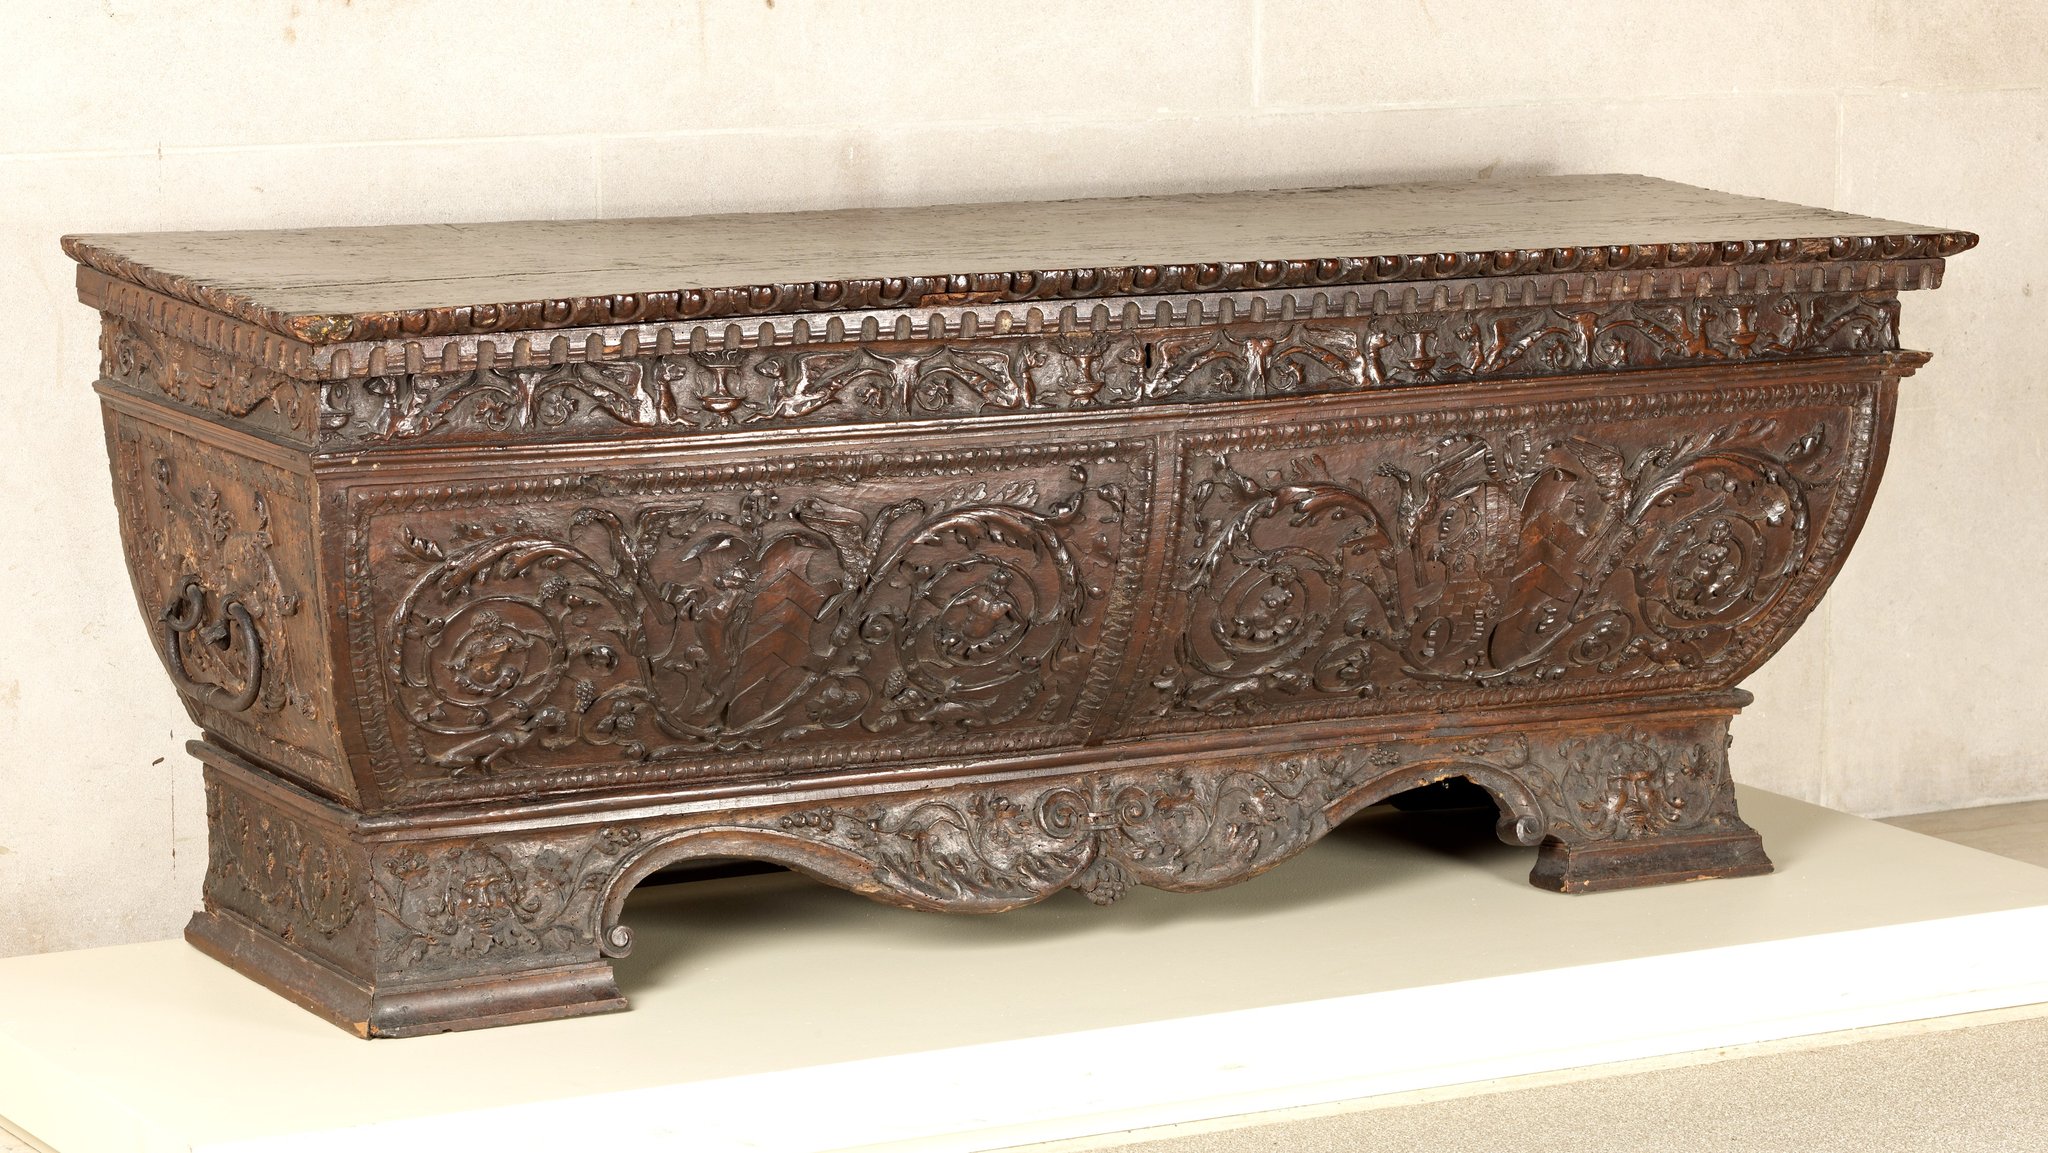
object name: cassone chest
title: Cassone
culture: north italian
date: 1500-1525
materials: wood, iron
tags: birds,coat of arms